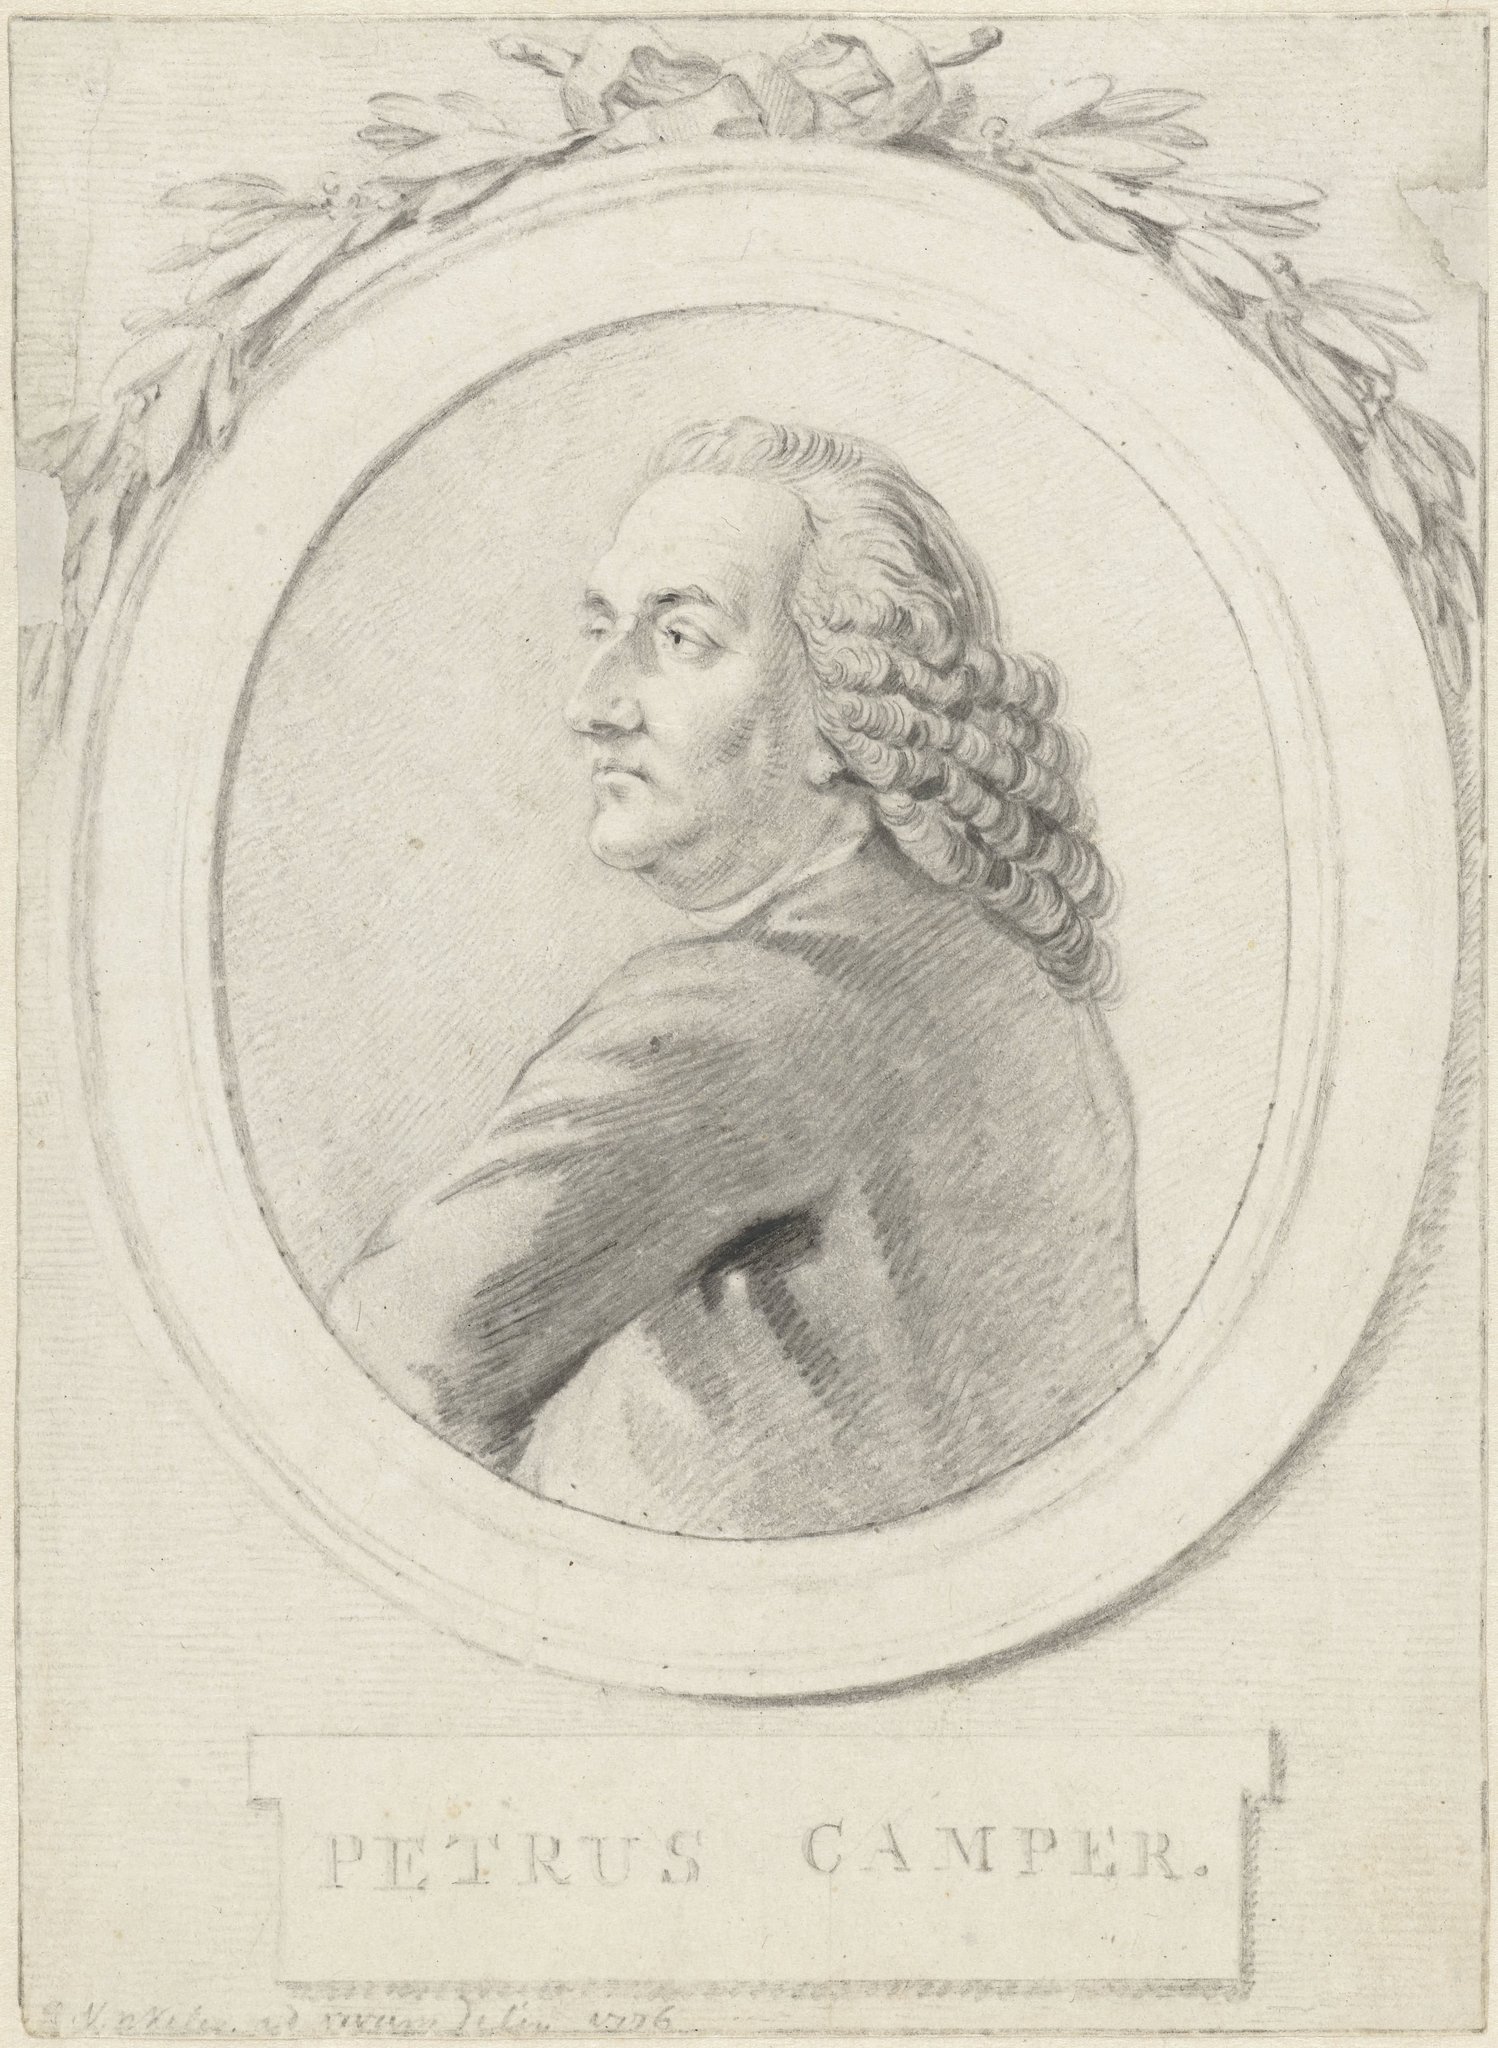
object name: design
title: Portret van professor Petrus Camper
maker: reinier vinkeles (i)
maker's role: draughtsman, print maker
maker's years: 1741-1816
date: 1776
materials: ink, paper, pencil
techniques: pen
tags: leiden, the hague, print maker, draughtsman, petrus camper, historical persons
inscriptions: inscription: ‘Gebor. te Leijde 11 Mei 1722 / Hoogleeraar in de Anat. Chir. et Med. / 1755 overl. 7 April 1789 / 28 / R. Vinkeles’, inscription: ‘PETRUS CAMPER / R. Vinkeles ad vivam delin 1776’